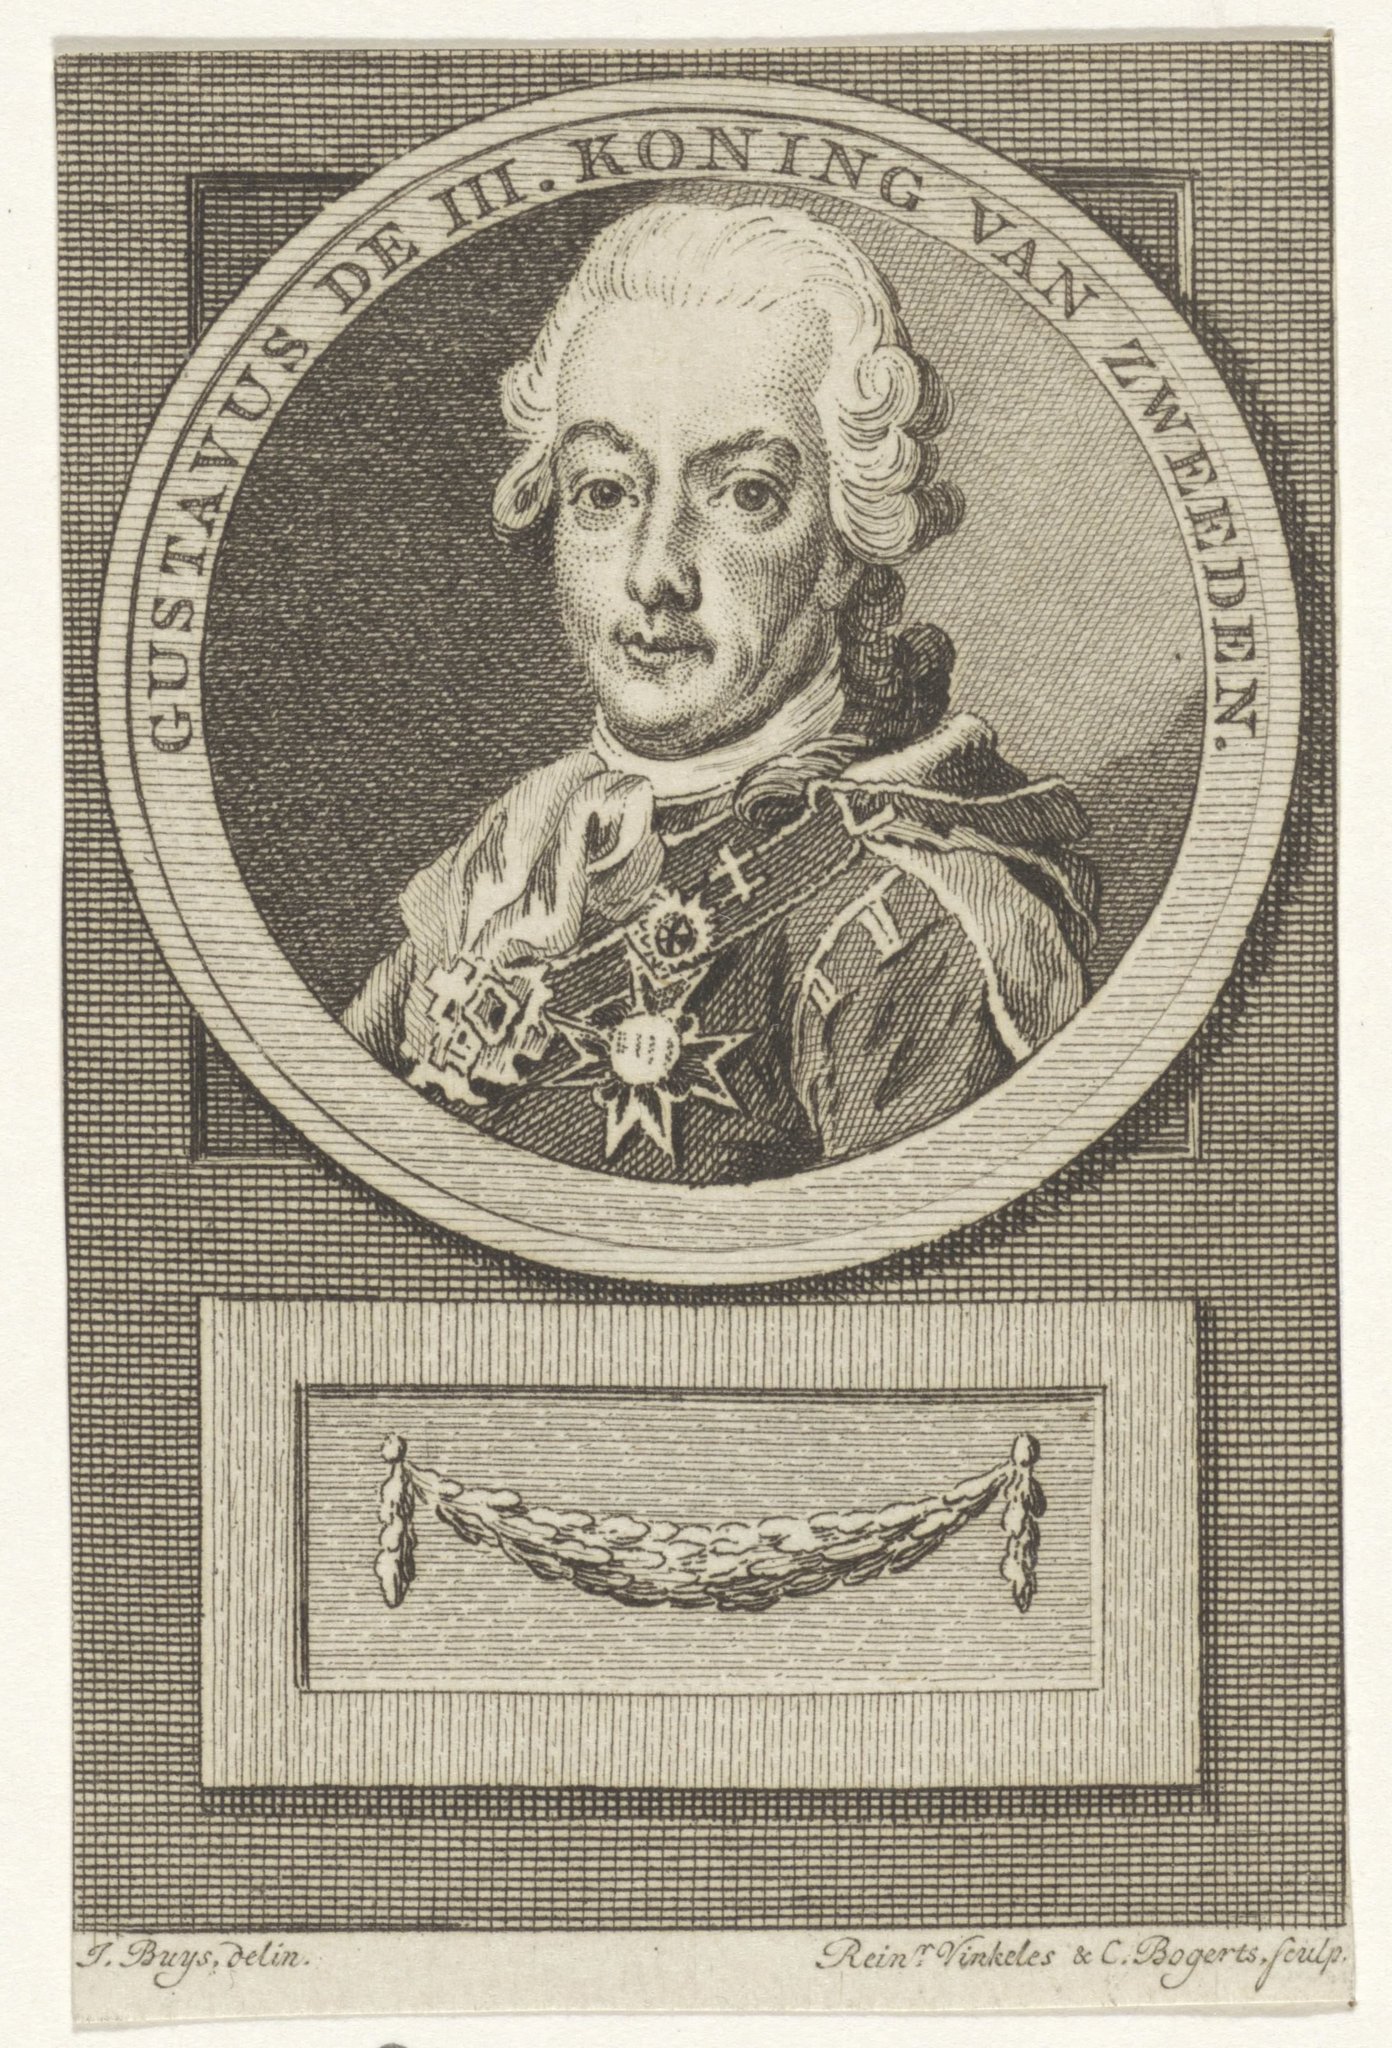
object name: book illustration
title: Portret van Gustaaf III, koning van Zweden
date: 1783-1795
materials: paper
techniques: engraving, etching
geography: amsterdam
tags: stockholm, koning, gustaaf iii (koning van zweden)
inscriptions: collector's mark: Lugt 2228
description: Latere staat prent gebruikt in: Fokke, Jan. Geschiedenissen der Vereenigde Nederlanden voor de vaderlandsche jeugd Ie-XXVste deel. Amsterdam: Johannes Allart, 1783-1795.